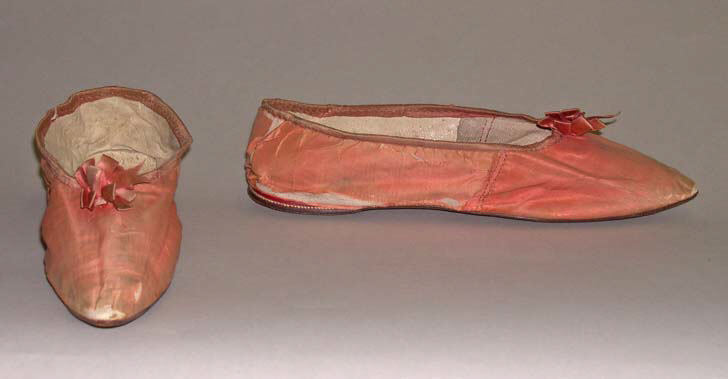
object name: slipper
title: Slippers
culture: british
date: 1800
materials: leather, silk